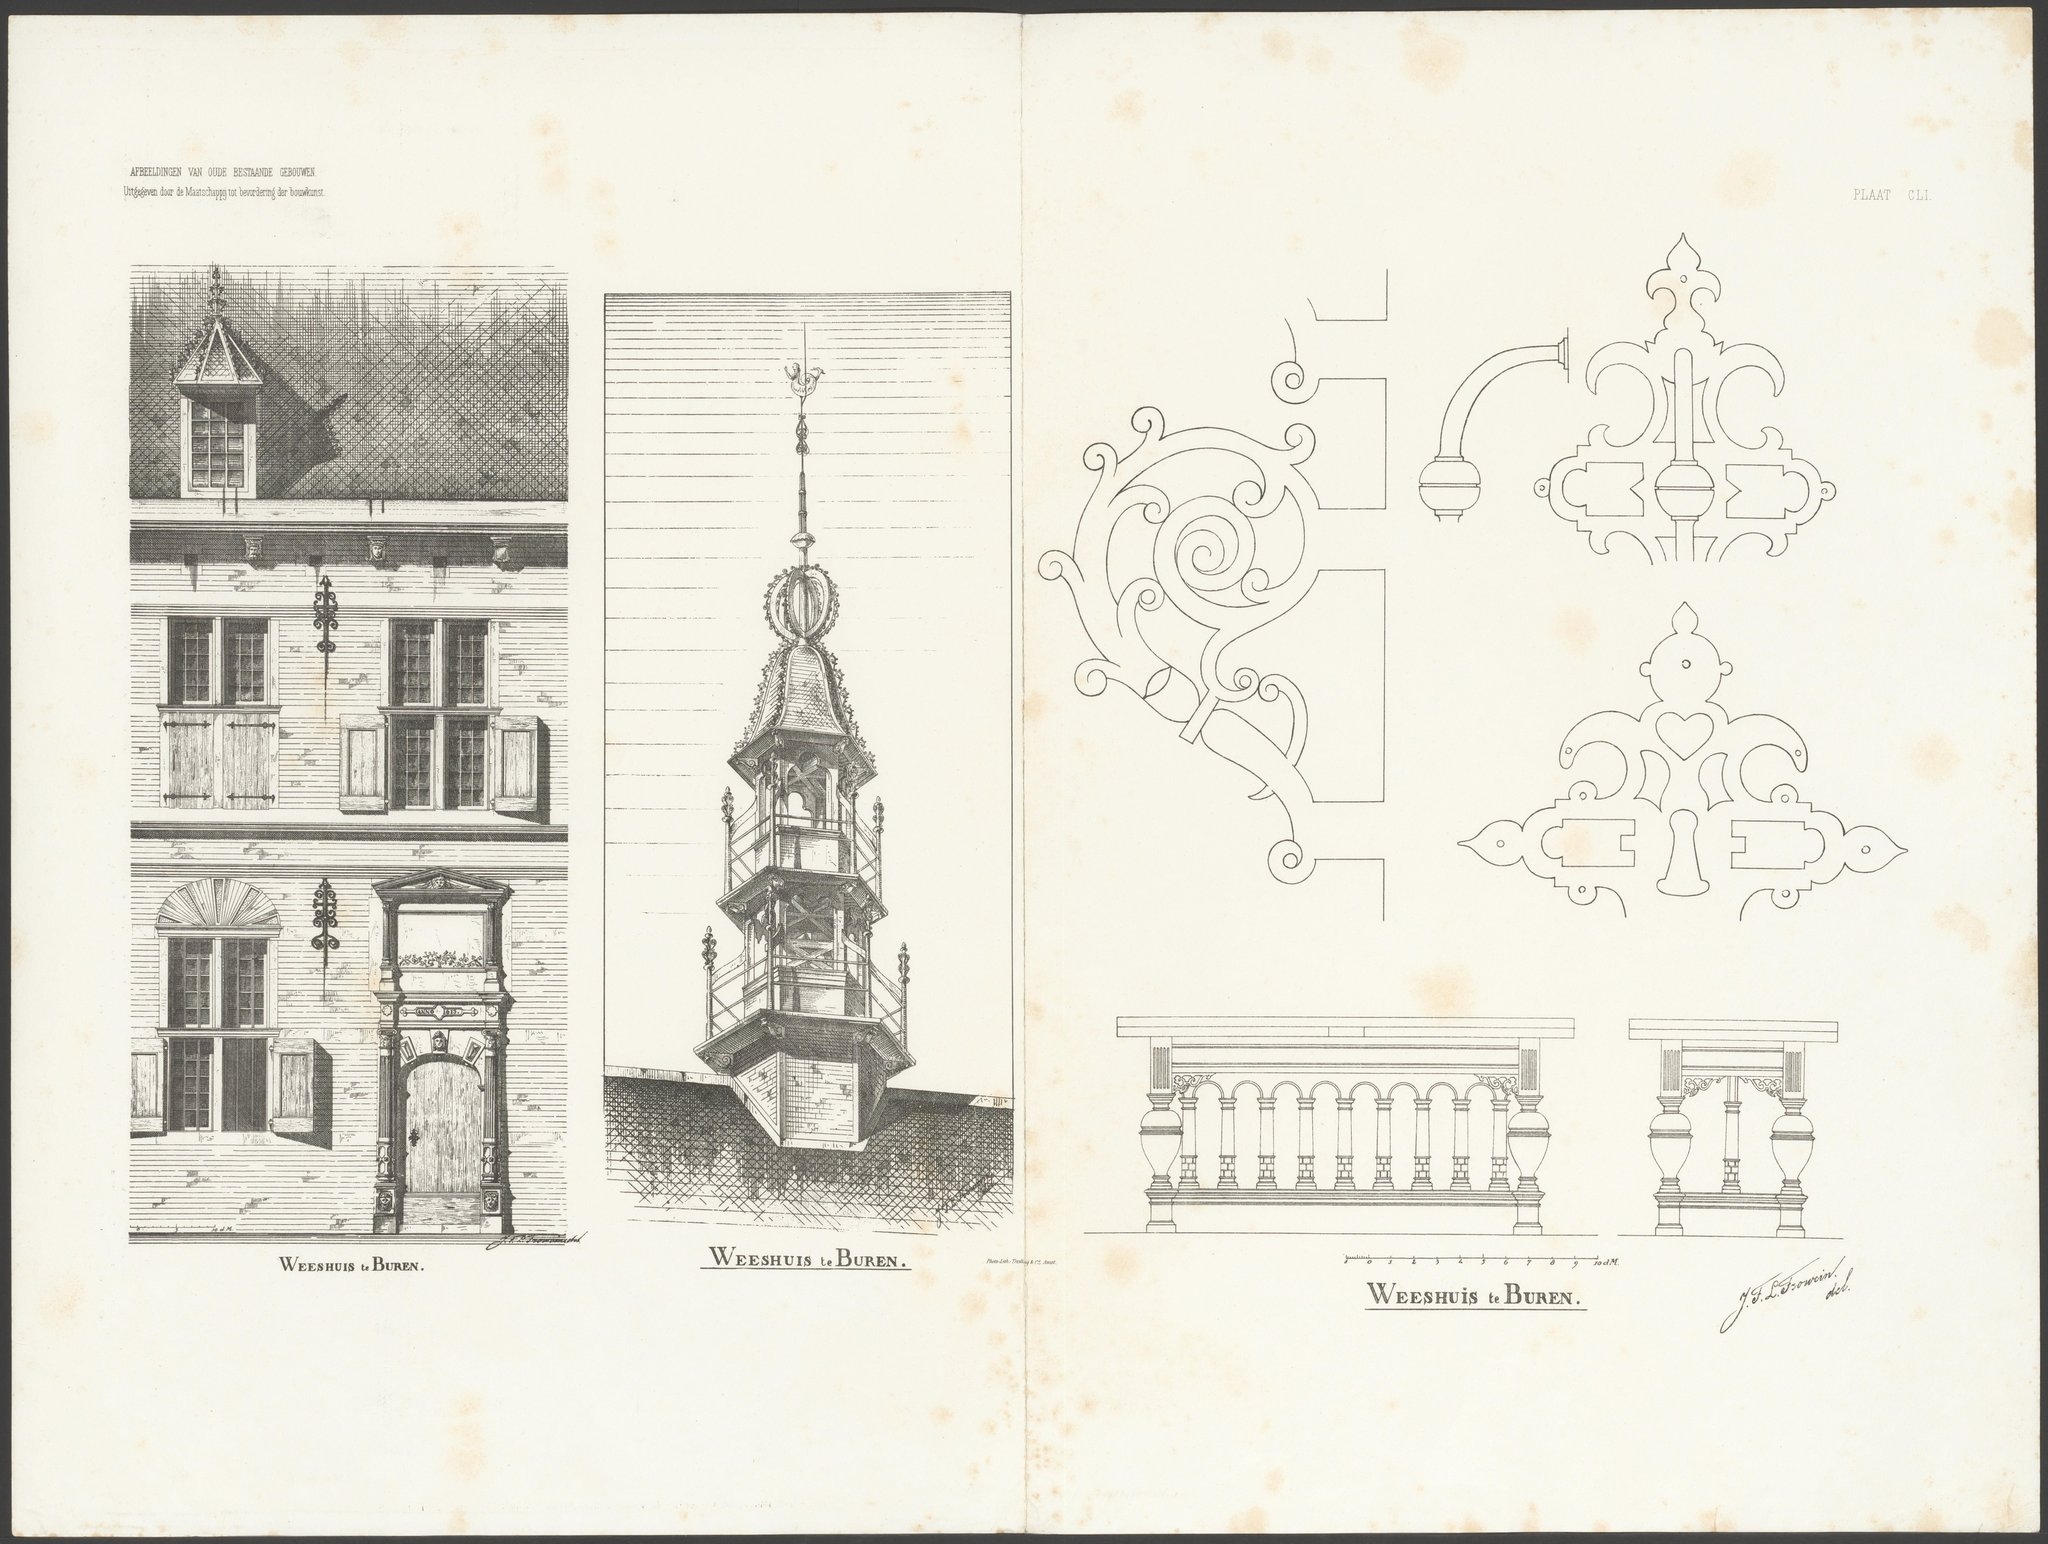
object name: photomechanical print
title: Weeshuis te Buren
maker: jan frederik lodewijk frowein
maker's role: draughtsman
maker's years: 1855-1914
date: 1870-1907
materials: paper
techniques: photolithography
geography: amsterdam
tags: architectural detail, orphanage, front façade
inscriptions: collector's mark, collector's mark: Lugt 1641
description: Detail van de voorgevel, de toren en enkele andere details van de weeshuis te Buren. Onderaan een schaalstok. Architectuurvoorstelling. Plaat CLI. Onderwerpsrubrieken binnen de Atlas Zeden en Gewoonten: Armwezen en Liefdadigheid.